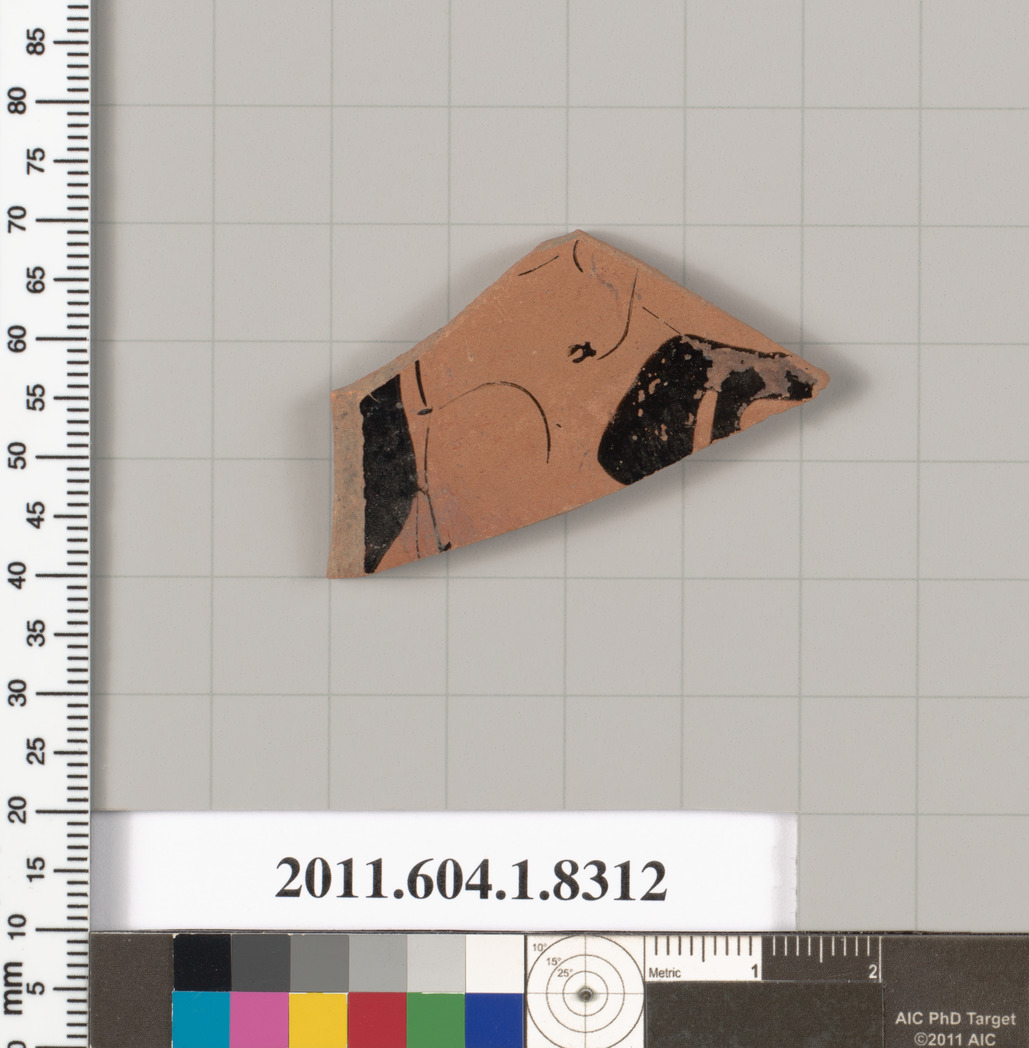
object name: kylix fragment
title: Terracotta fragment of a kylix (drinking cup)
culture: greek, attic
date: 425-401 BCE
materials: terracotta